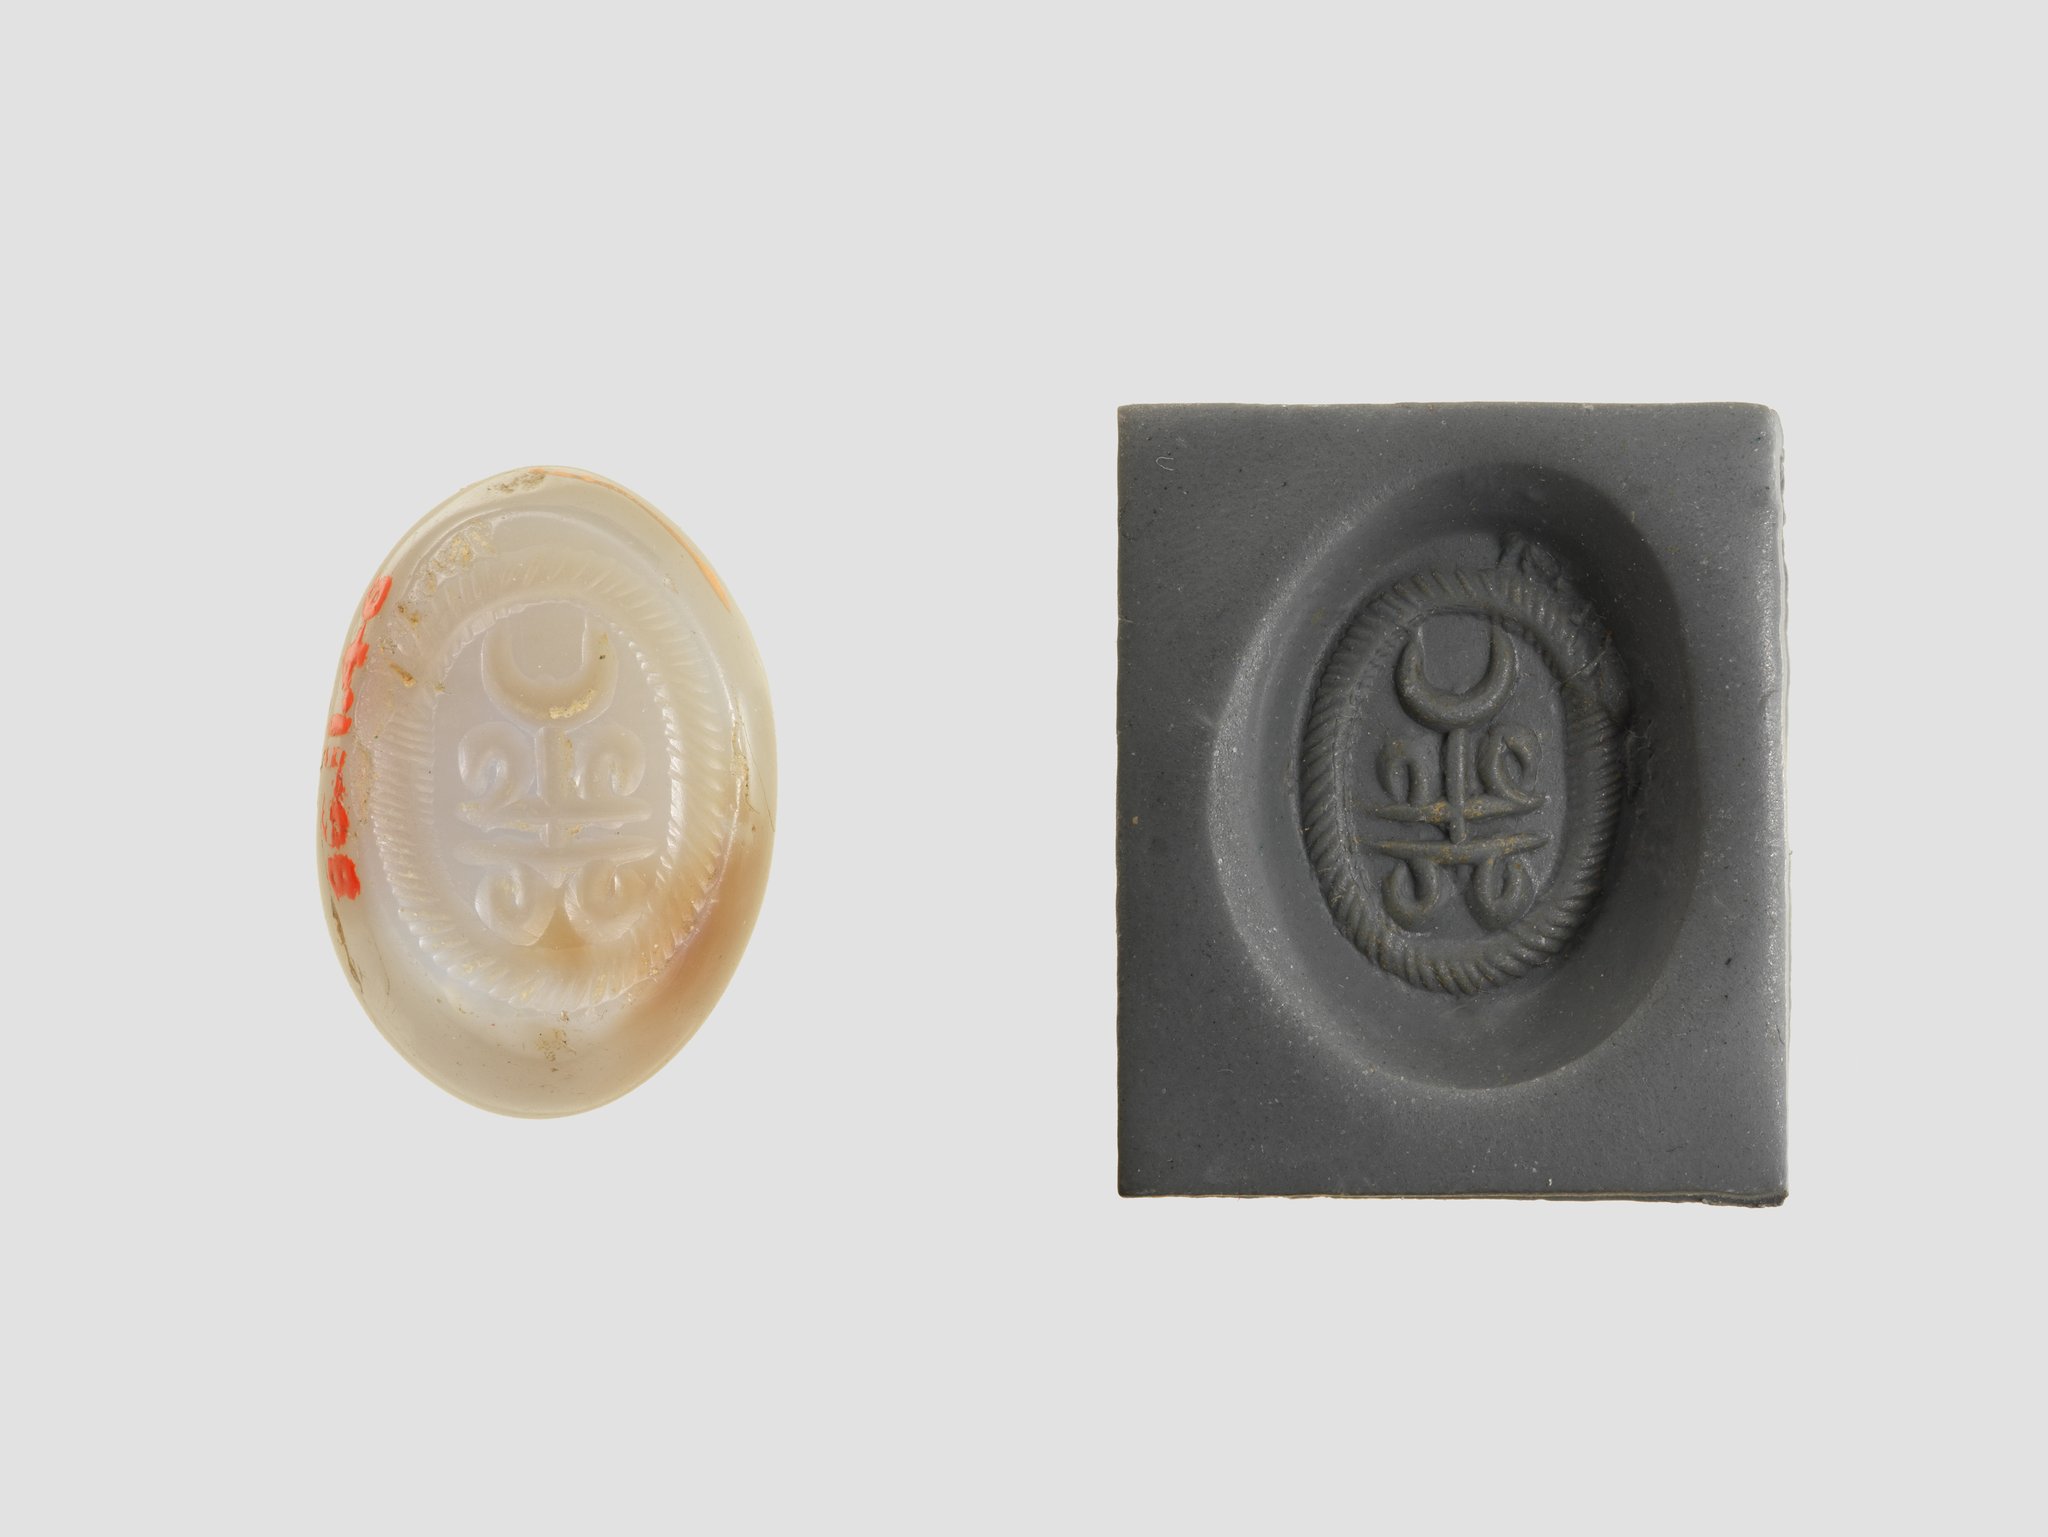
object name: stamp seal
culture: sasanian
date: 201-700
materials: stone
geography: iran or mesopotamia